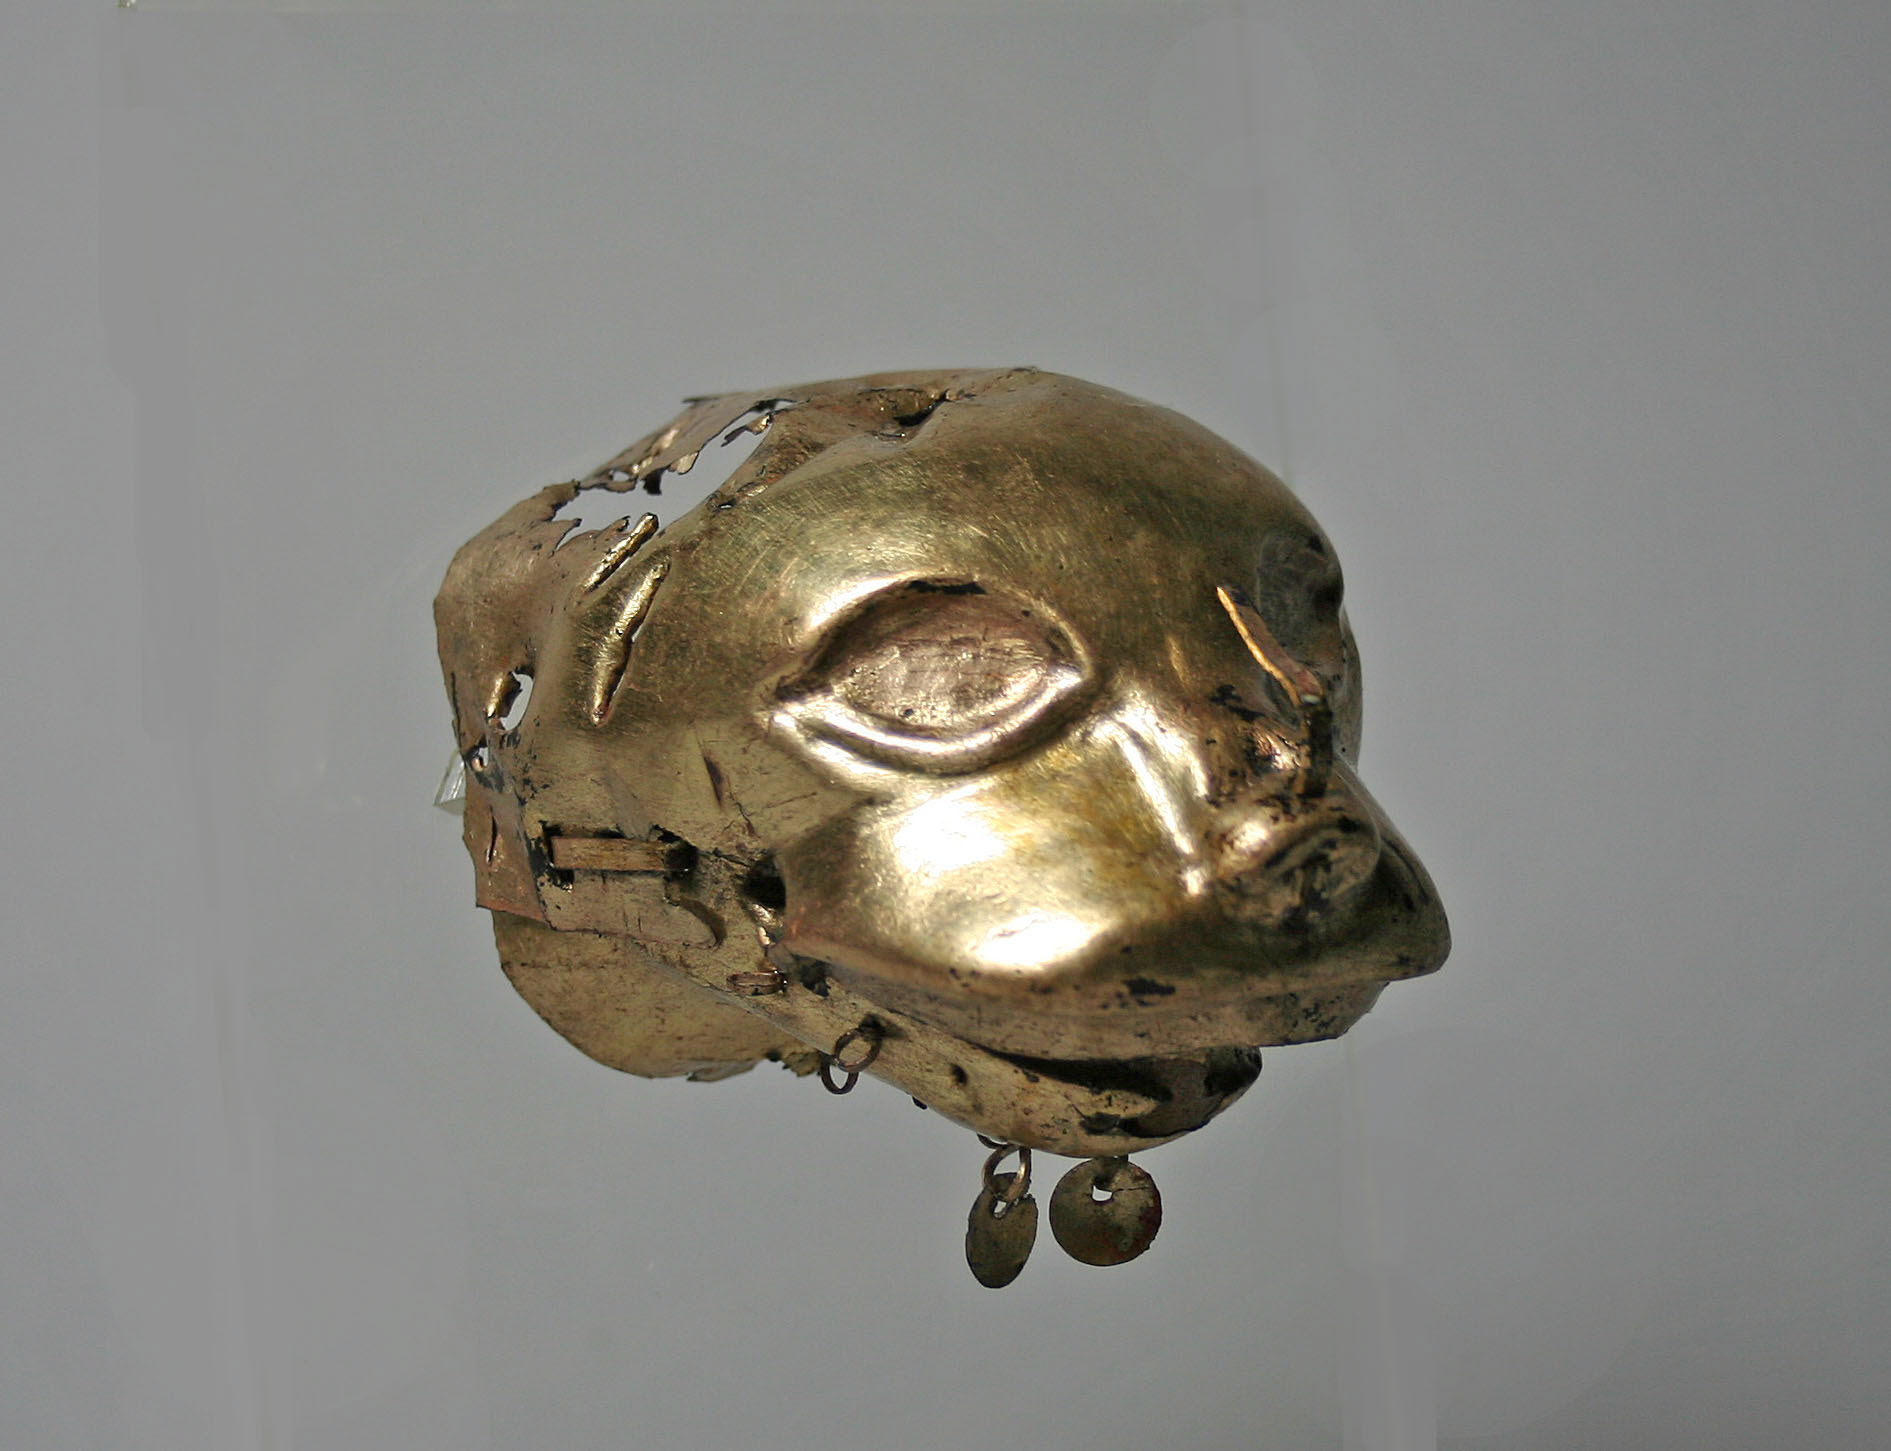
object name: ornament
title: Feline Ornament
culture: moche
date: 501-700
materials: gilt copper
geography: peru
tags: cats